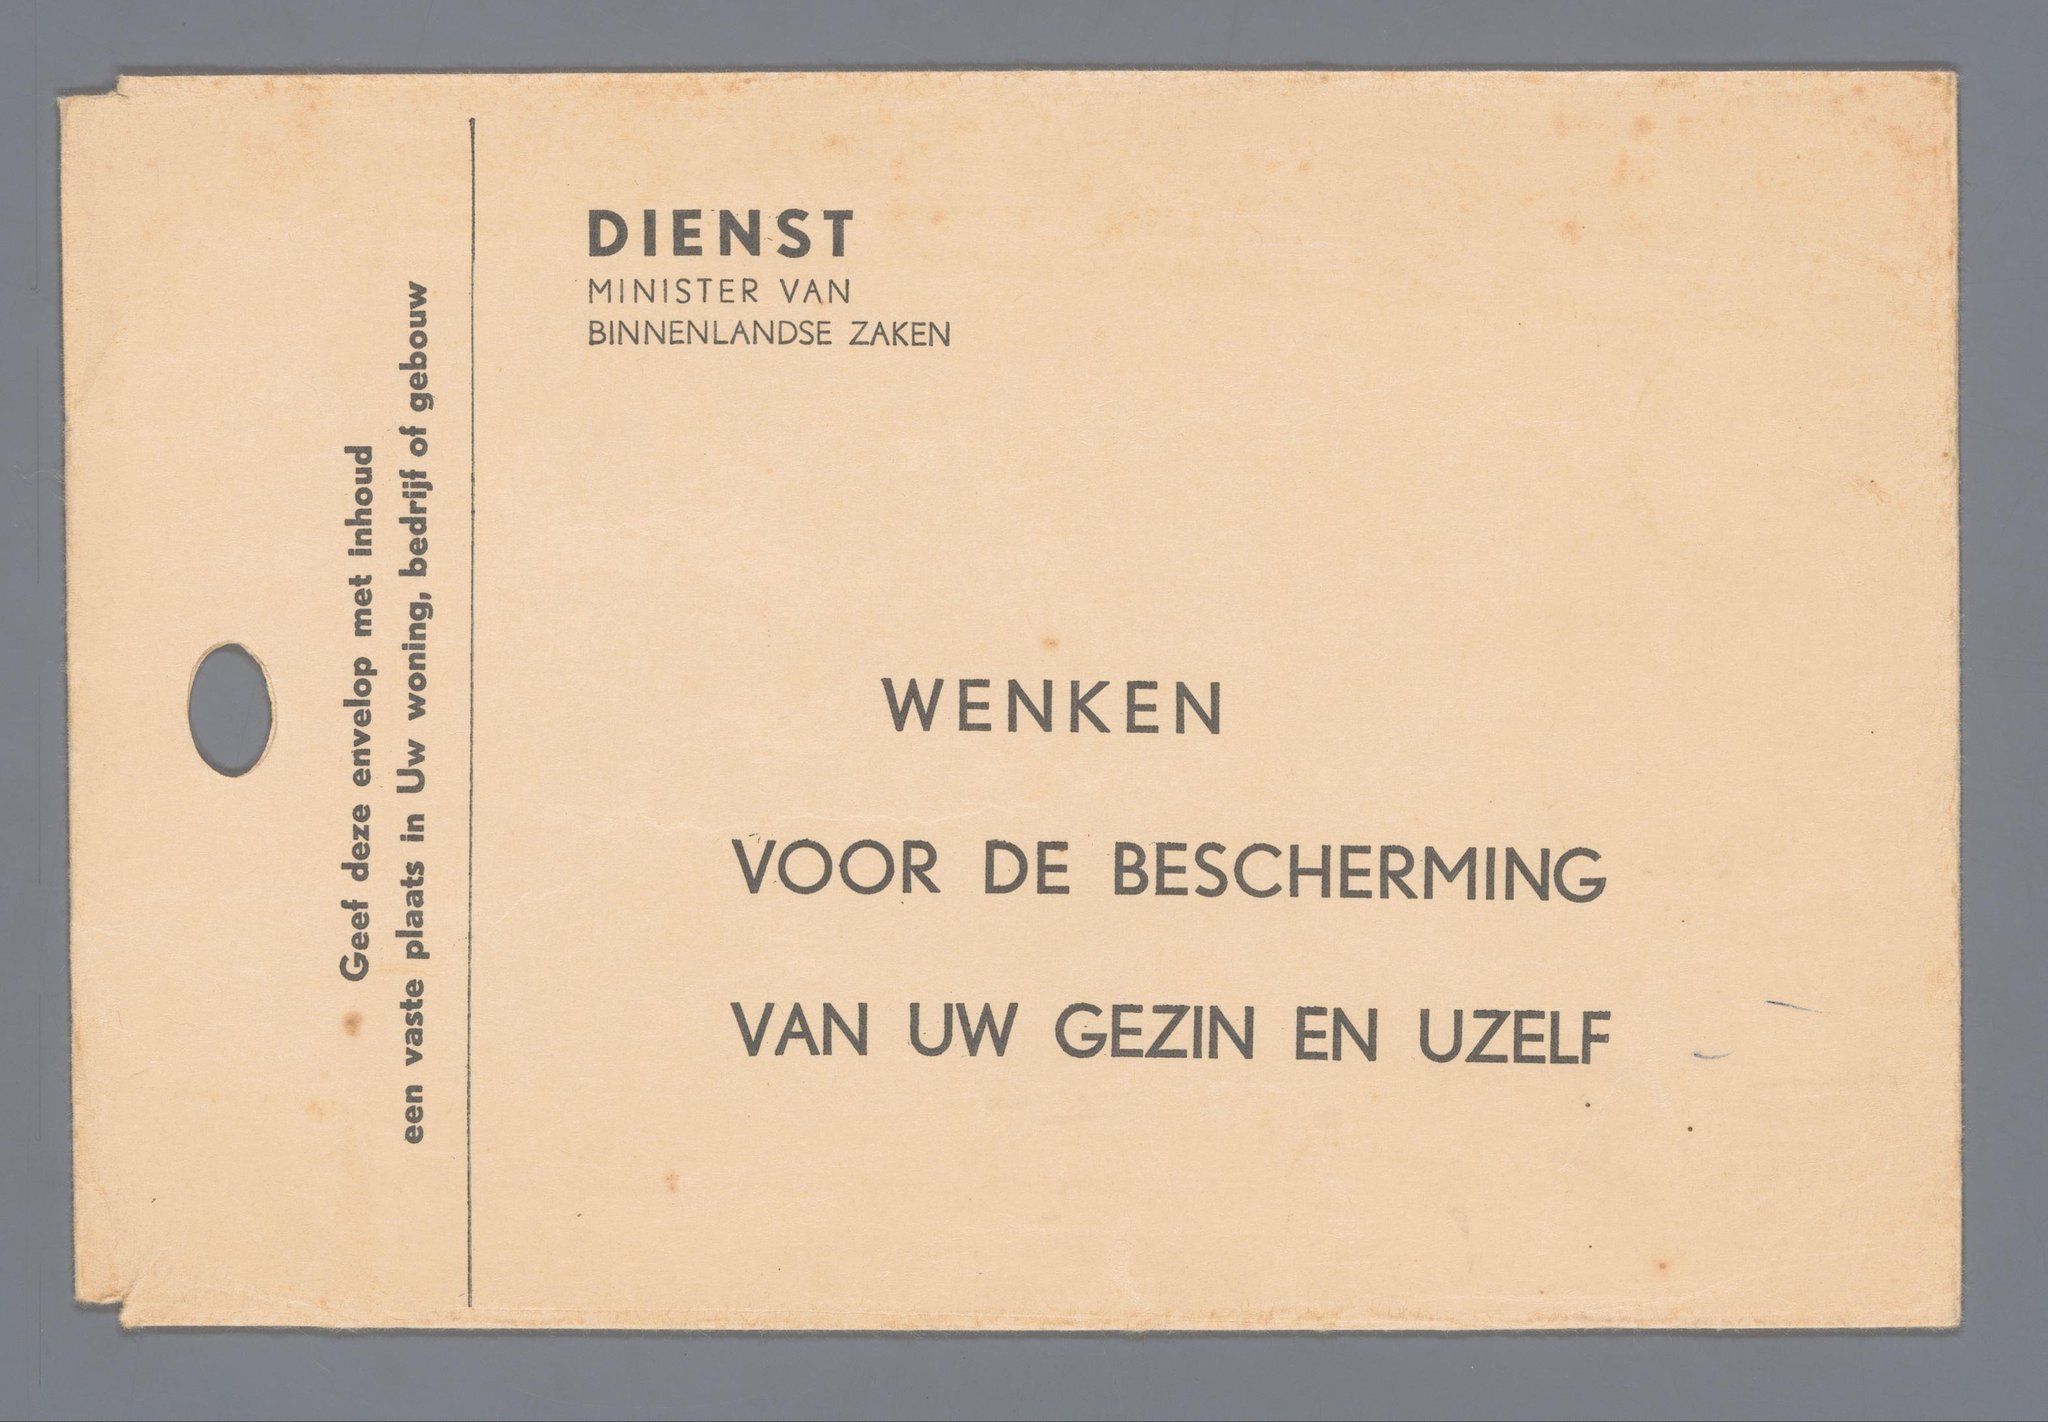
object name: envelope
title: Wenken voor de bescherming van uw gezin en uzelf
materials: paper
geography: the hague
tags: netherlands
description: Envelop met daarin 3 brochures over de periode van de Koude Oorlog.